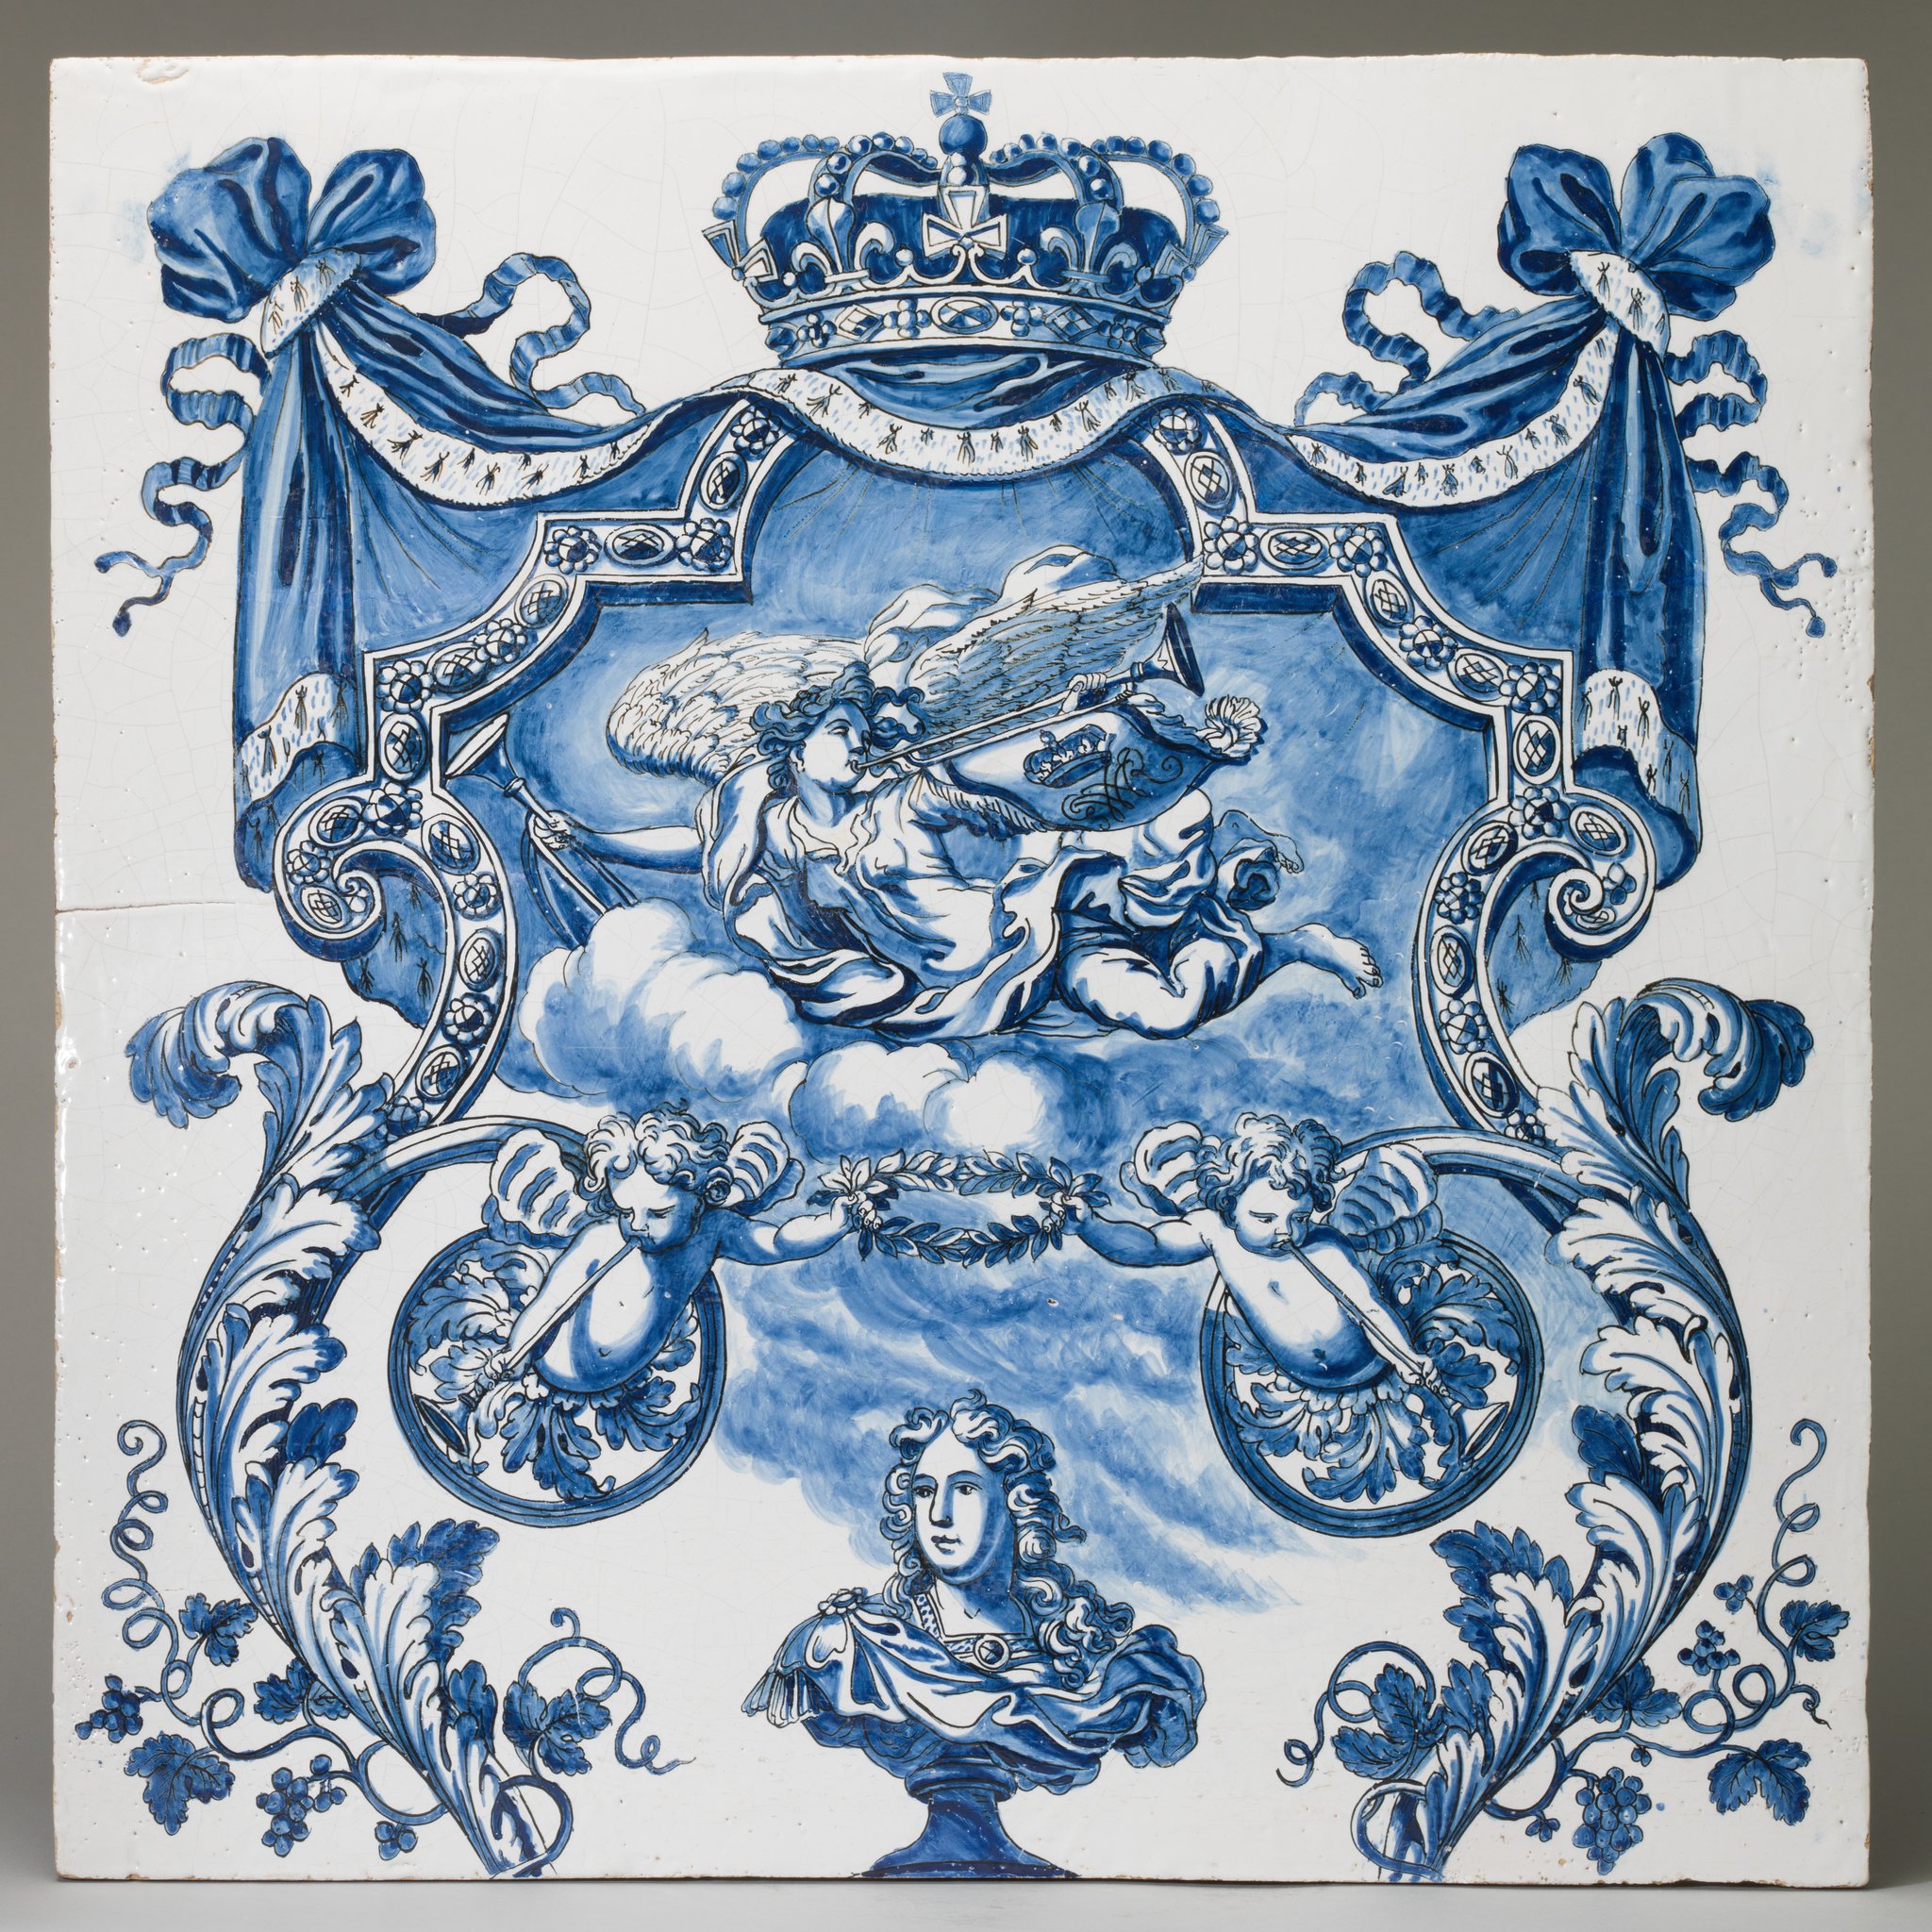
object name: tile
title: Tile with a bust of William III (1650–1702)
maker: adrianus kocx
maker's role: factory director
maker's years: 1689-1694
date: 1694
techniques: glazing